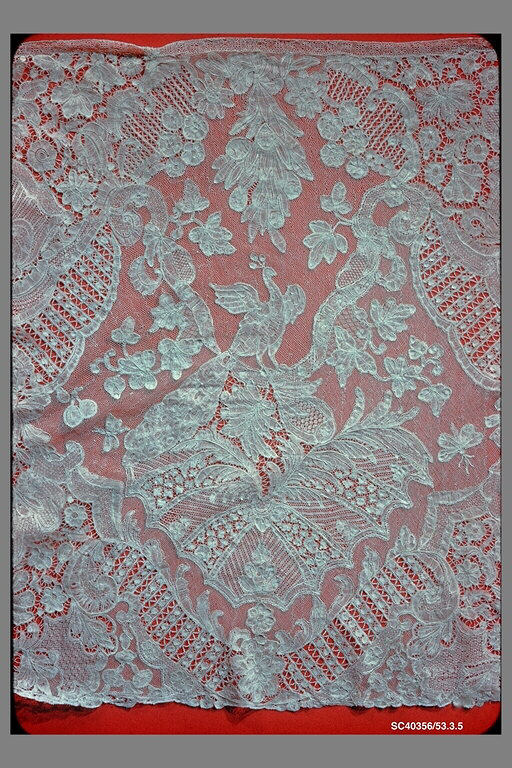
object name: flounce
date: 1701-1800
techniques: lace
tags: fruit,peacocks,flowers